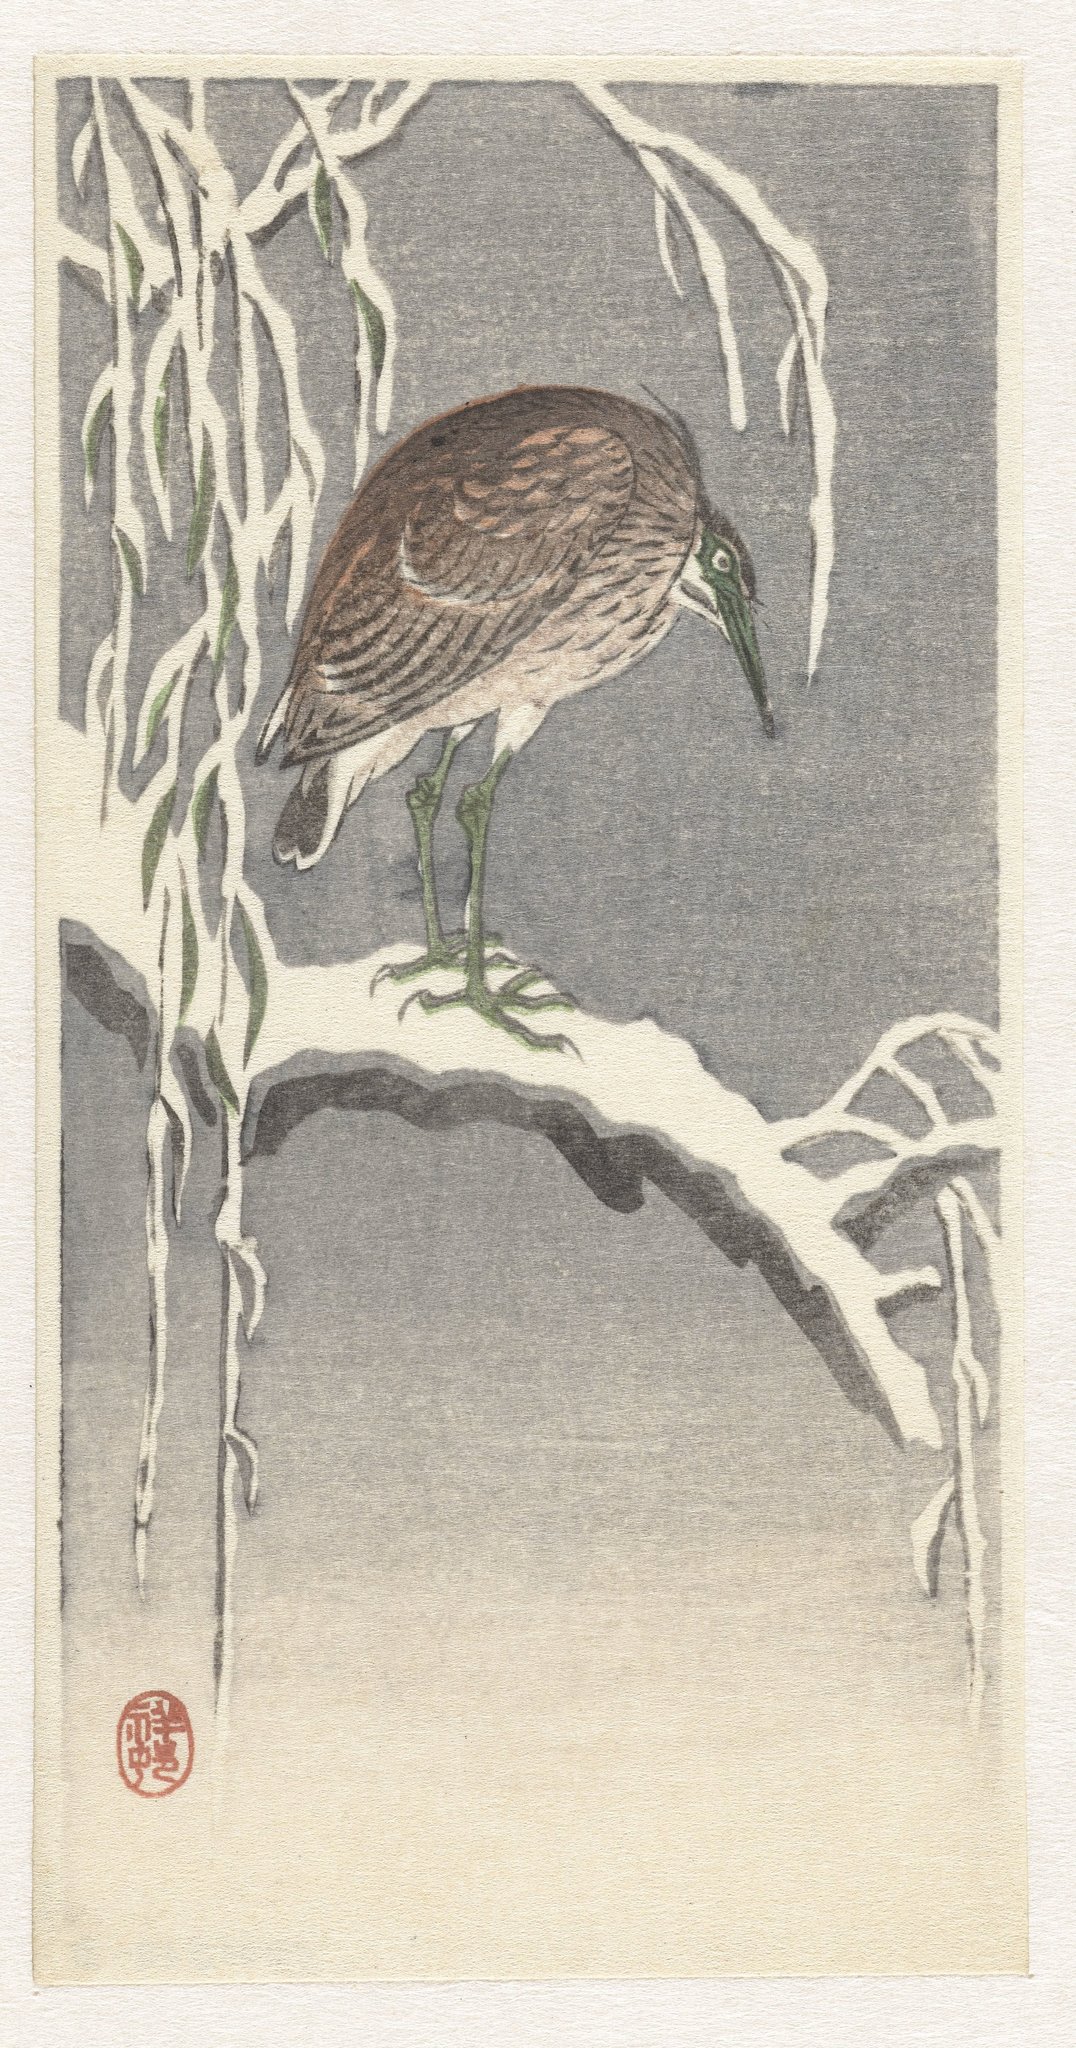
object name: print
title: Reiger op besneeuwde boomtak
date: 1925-1936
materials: paper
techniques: woodcut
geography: tokyo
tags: shore-birds and wading-birds: heron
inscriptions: collector's mark: Lugt 2228